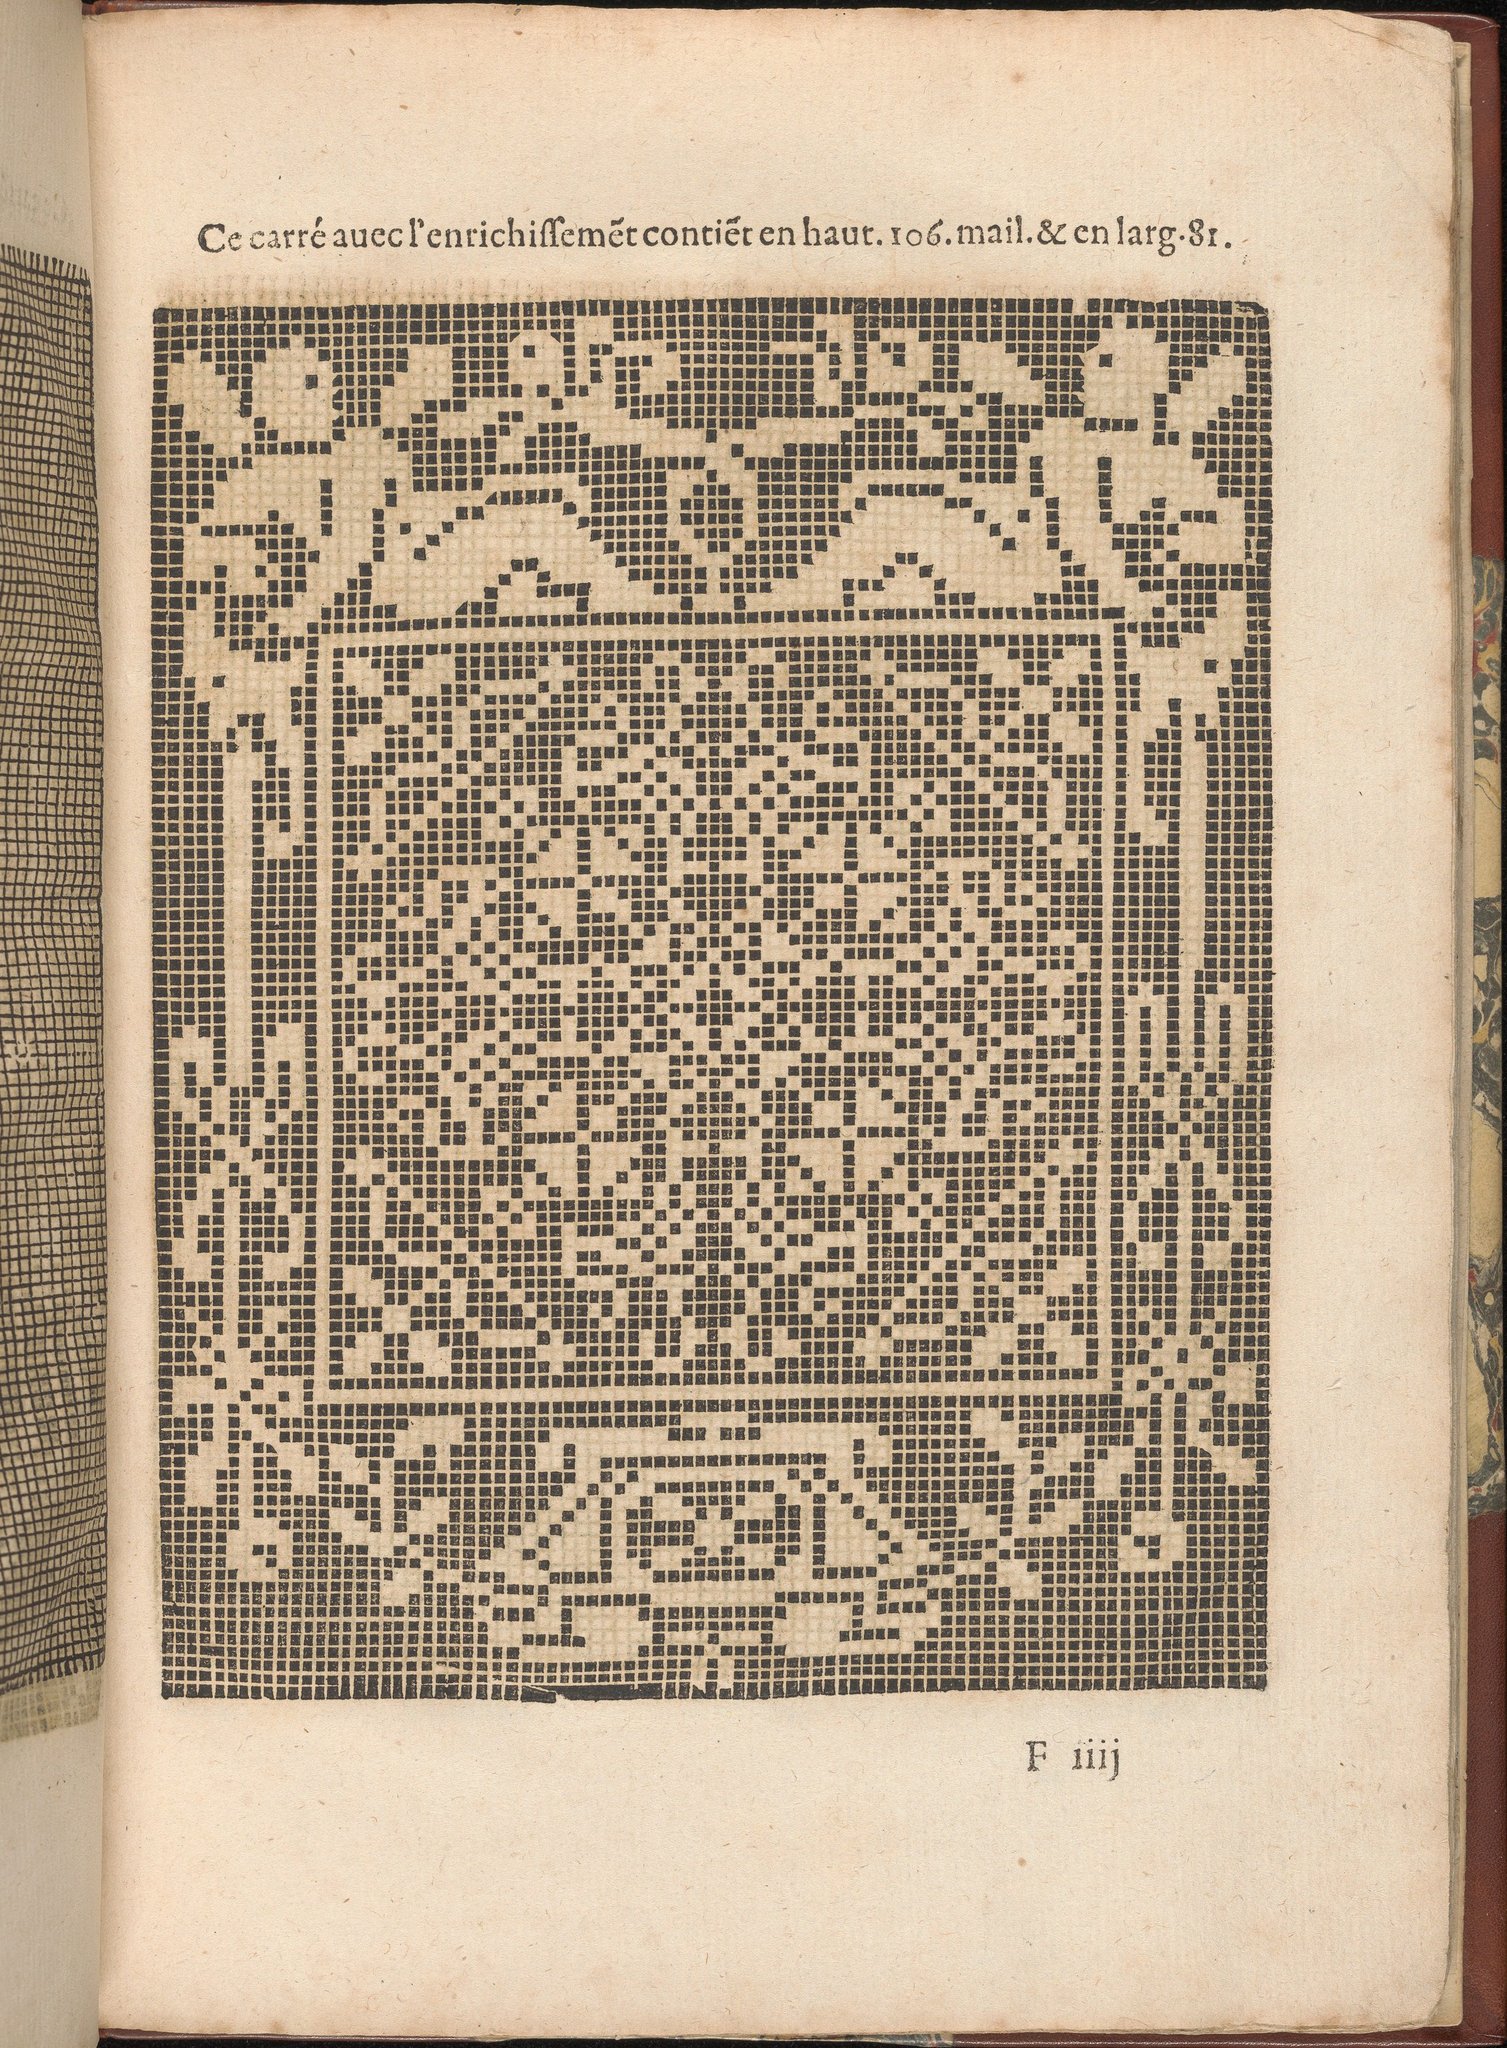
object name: book print ornament architecture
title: Les Secondes Oeuvres, et Subtiles Inventions De Lingerie du Seigneur Federic de Vinciolo Venitien, page 24 (recto)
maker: federico de vinciolo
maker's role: designer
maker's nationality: italian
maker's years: 1582-1599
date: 1603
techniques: woodcut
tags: flowers